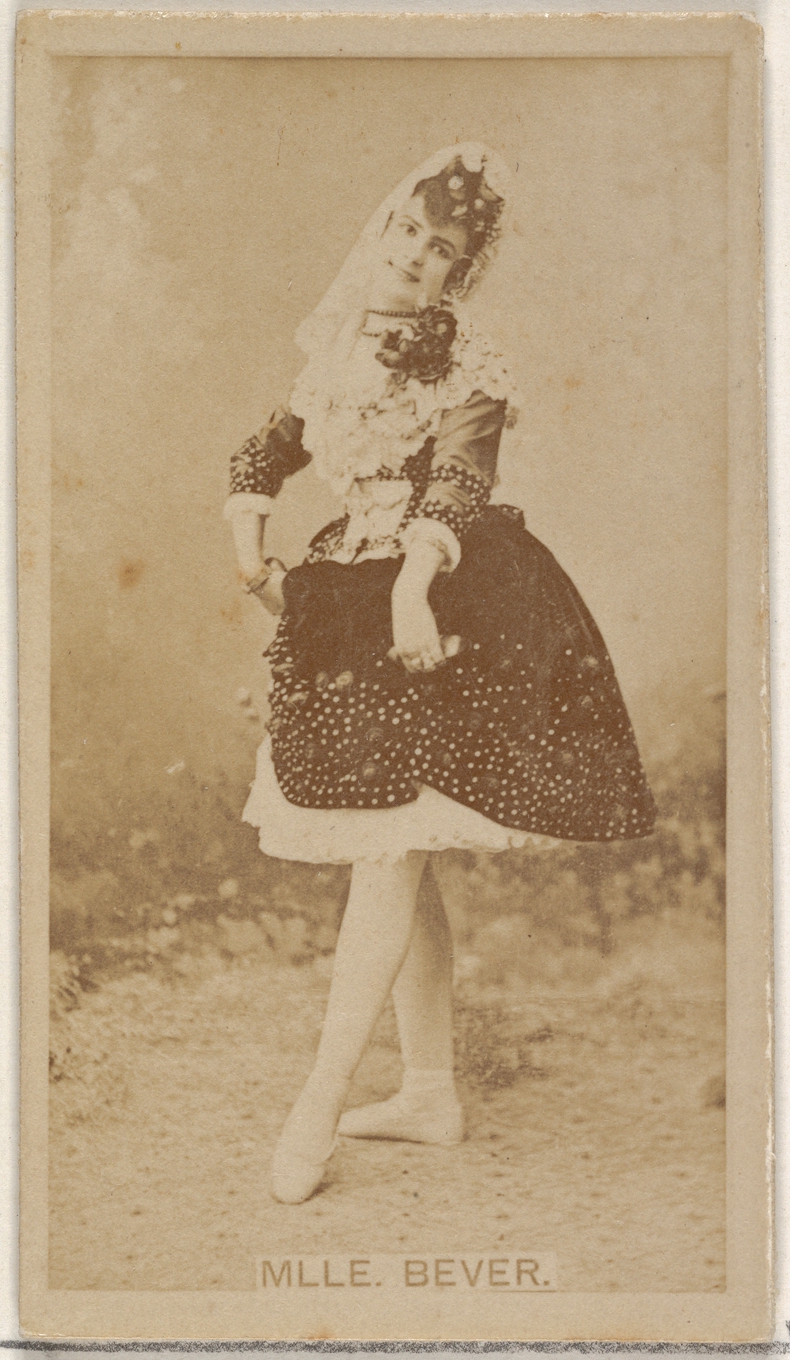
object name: photograph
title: Mlle. Bever, from the Actors and Actresses series (N45, Type 8) for Virginia Brights Cigarettes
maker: allen & ginter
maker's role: publisher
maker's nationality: american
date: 1888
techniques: albumen silver print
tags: portraits,women,actresses